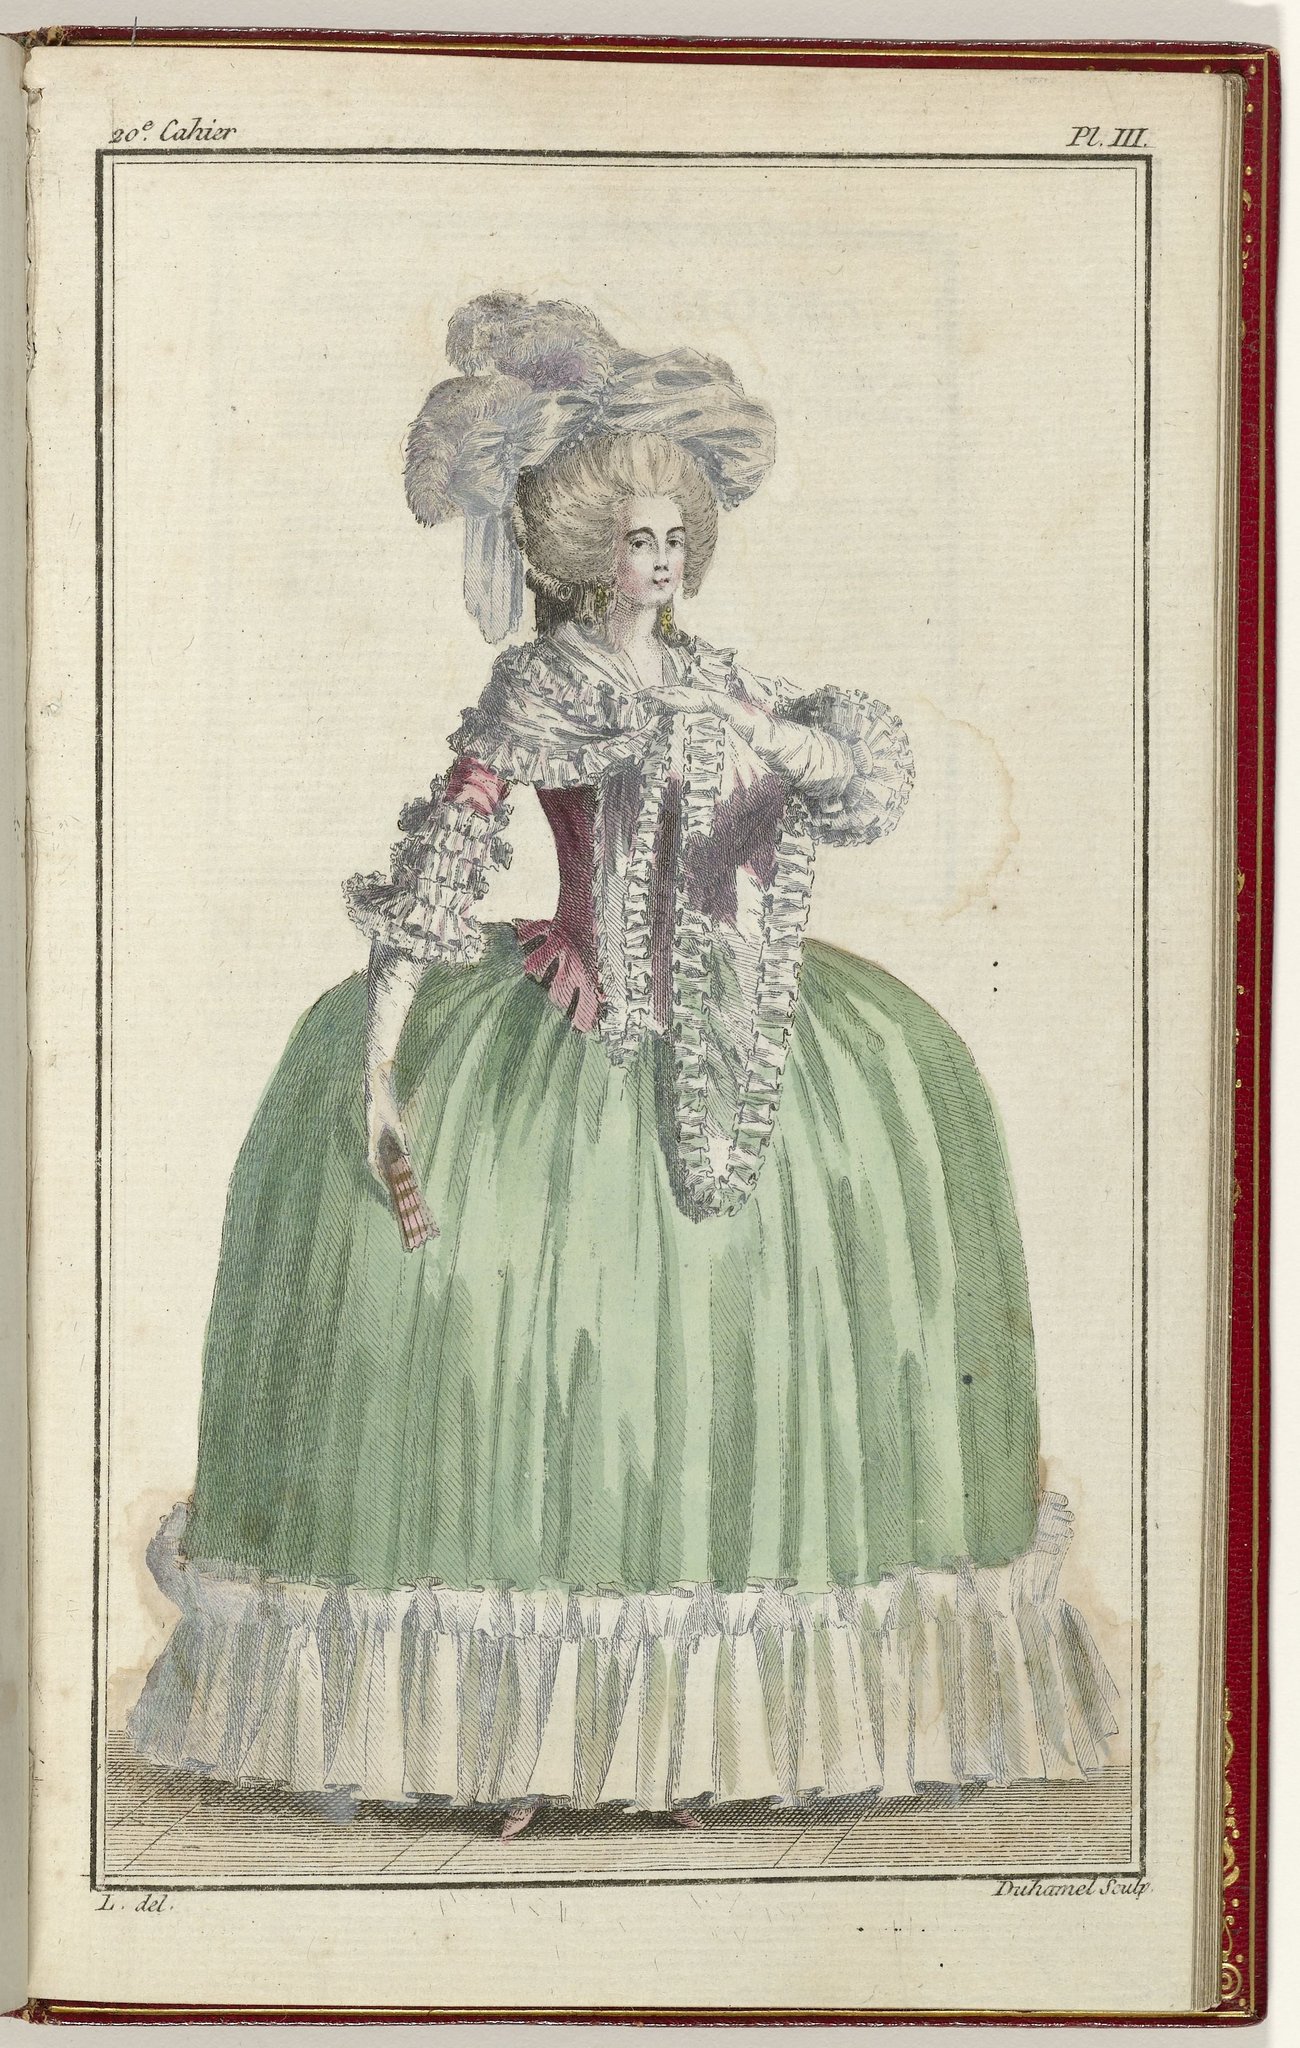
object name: fashion print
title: Cabinet des Modes ou les Modes Nouvelles, 1 Septembre 1786, pl. III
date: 1786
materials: paper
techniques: engraving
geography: paris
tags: ear-rings (+ women's clothes), dress, gown: court gown or court dress (+ women's clothes), gloves, mittens (long gloves) (+ women's clothes), clothing for the upper part of the body (mantelet) (+ women's clothes), styles of hairdress - aa - ~ women, head-gear: cap (+ women's clothes), fashion plates, skirt (+ women's clothes), sleeves (+ women's clothes)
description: Hofjapon. Volgens de begeleidende tekst draagt de vrouw een hofjapon, bestaande uit een lijfje van roze tafzijde en een rok van appelgroene tafzijde. Hierop een doorzichtige kleine schoudermantel van tule, afgezet met gerimpelde stroken. Op het hoge kapsel met krullen aan de zijkant een 'pouf' van witte gaze, versierd met een grote strik, parels en drie veren 'à la Folette'. Accessoires: oorbellen, lange handschoenen, roze schoenen, vouwwaaier. De prent maakt deel uit van het 20e Cahier uit Cabinet des Modes ou les Modes Nouvelles. De serie bestaat uit 72 modeprenten, uitgegeven door Buisson, Parijs, 15 november 1785 - 1 november 1786.